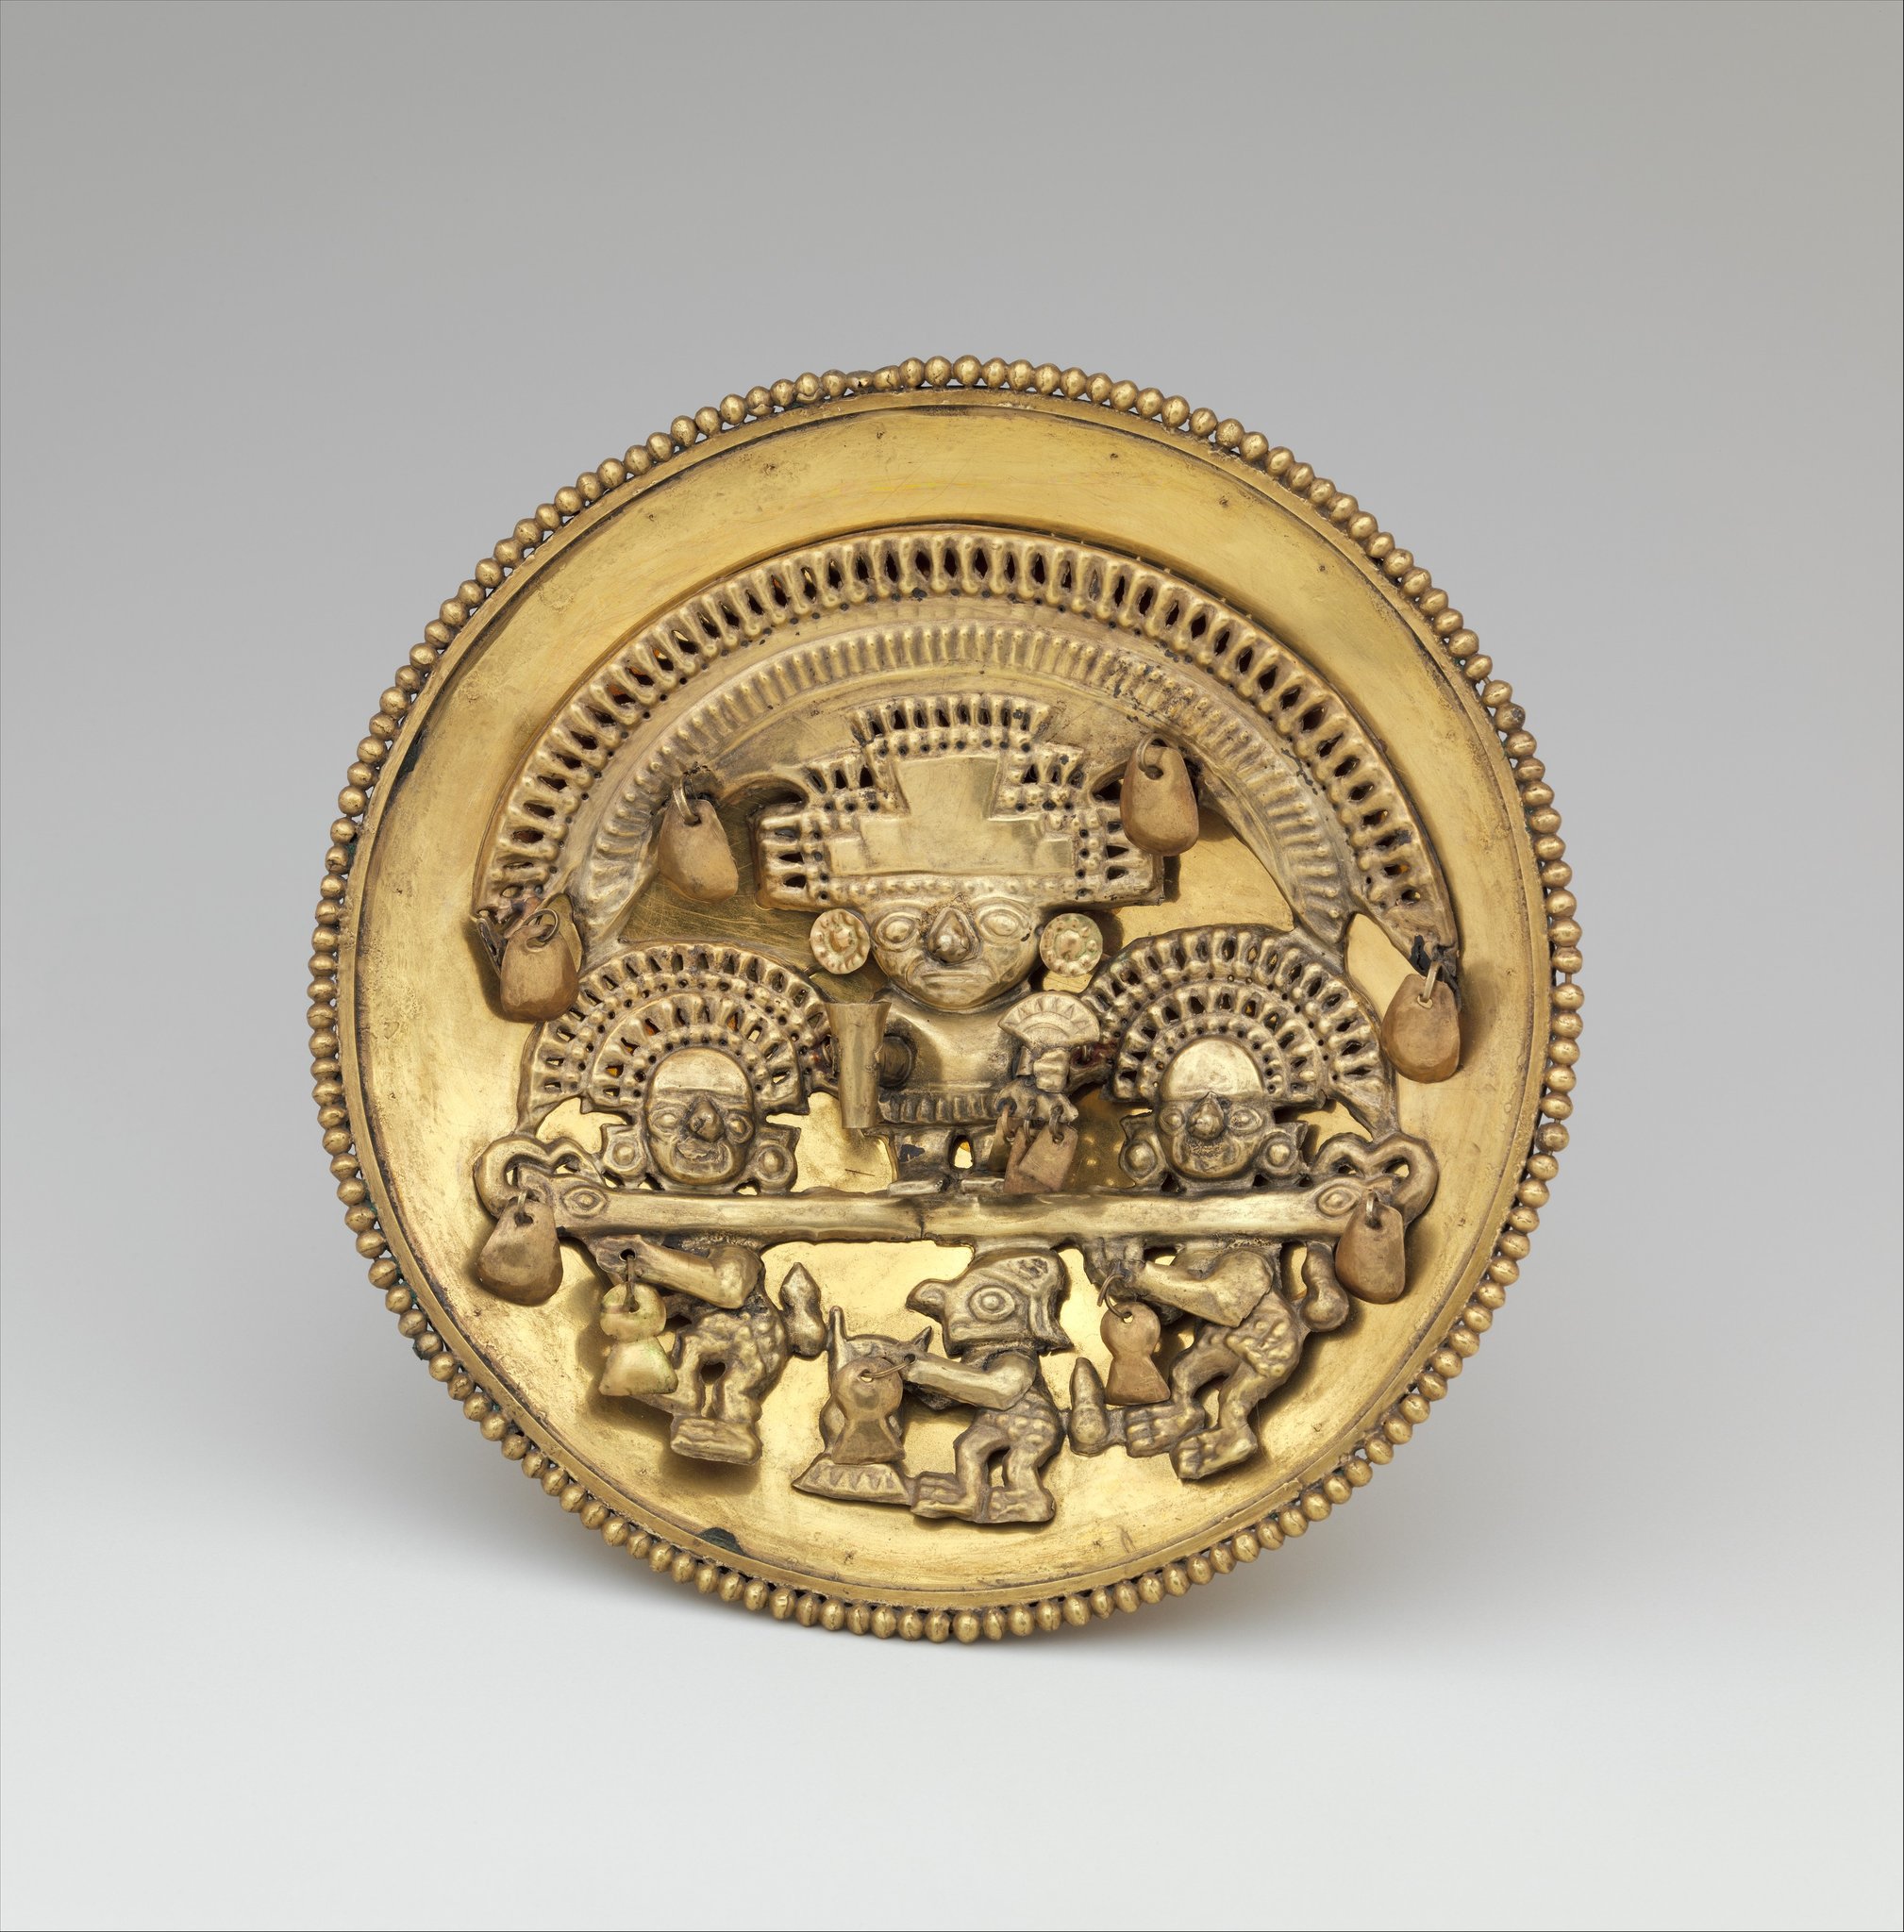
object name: earflare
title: Earflare with ritual procession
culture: chimú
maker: chimú artist(s)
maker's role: artist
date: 1350-1470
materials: gold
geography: peru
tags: men